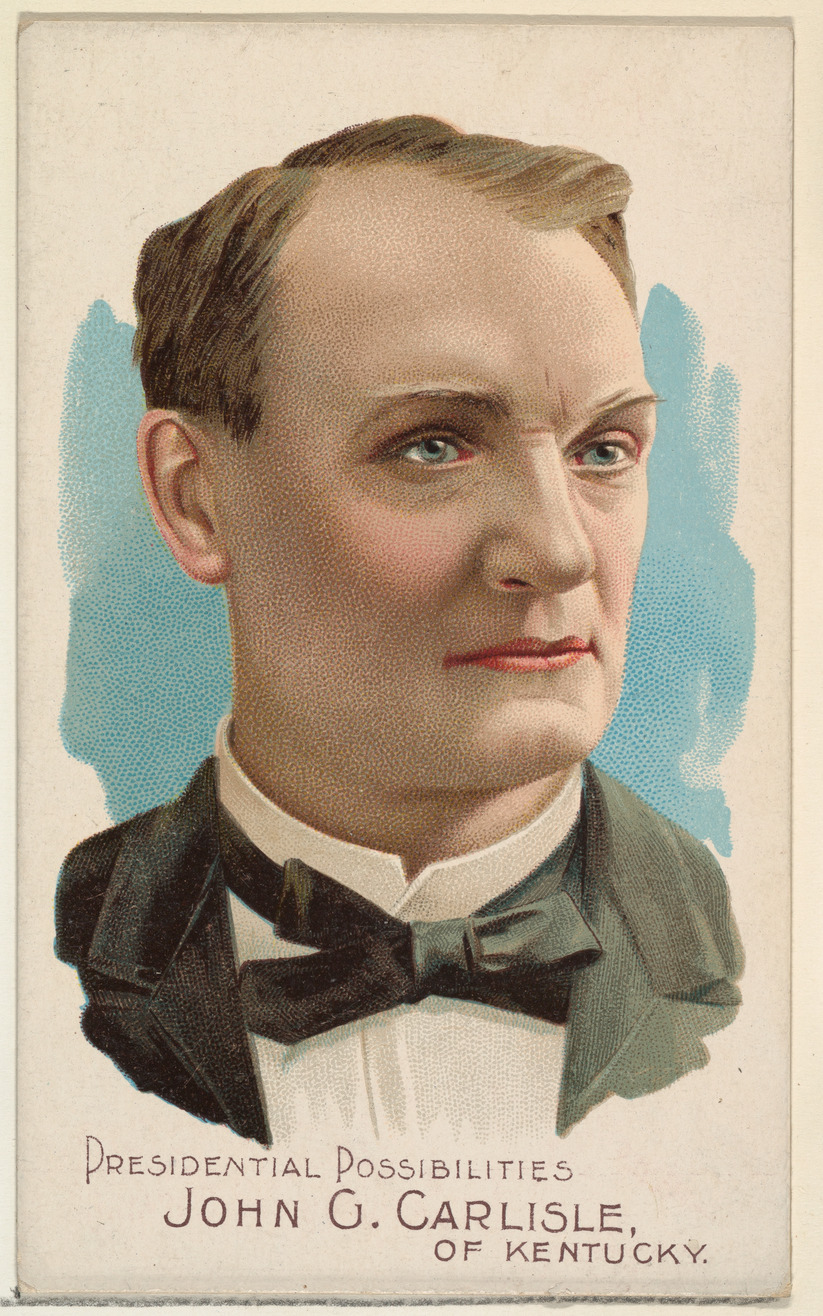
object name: print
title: John G. Carlisle of Kentucky, from the Presidential Possibilities series (N124) issued by Duke Sons & Co. to promote Honest Long Cut Tobacco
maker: w. duke, sons & co.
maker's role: publisher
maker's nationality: american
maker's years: 1870-1920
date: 1888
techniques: color lithograph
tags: men,portraits